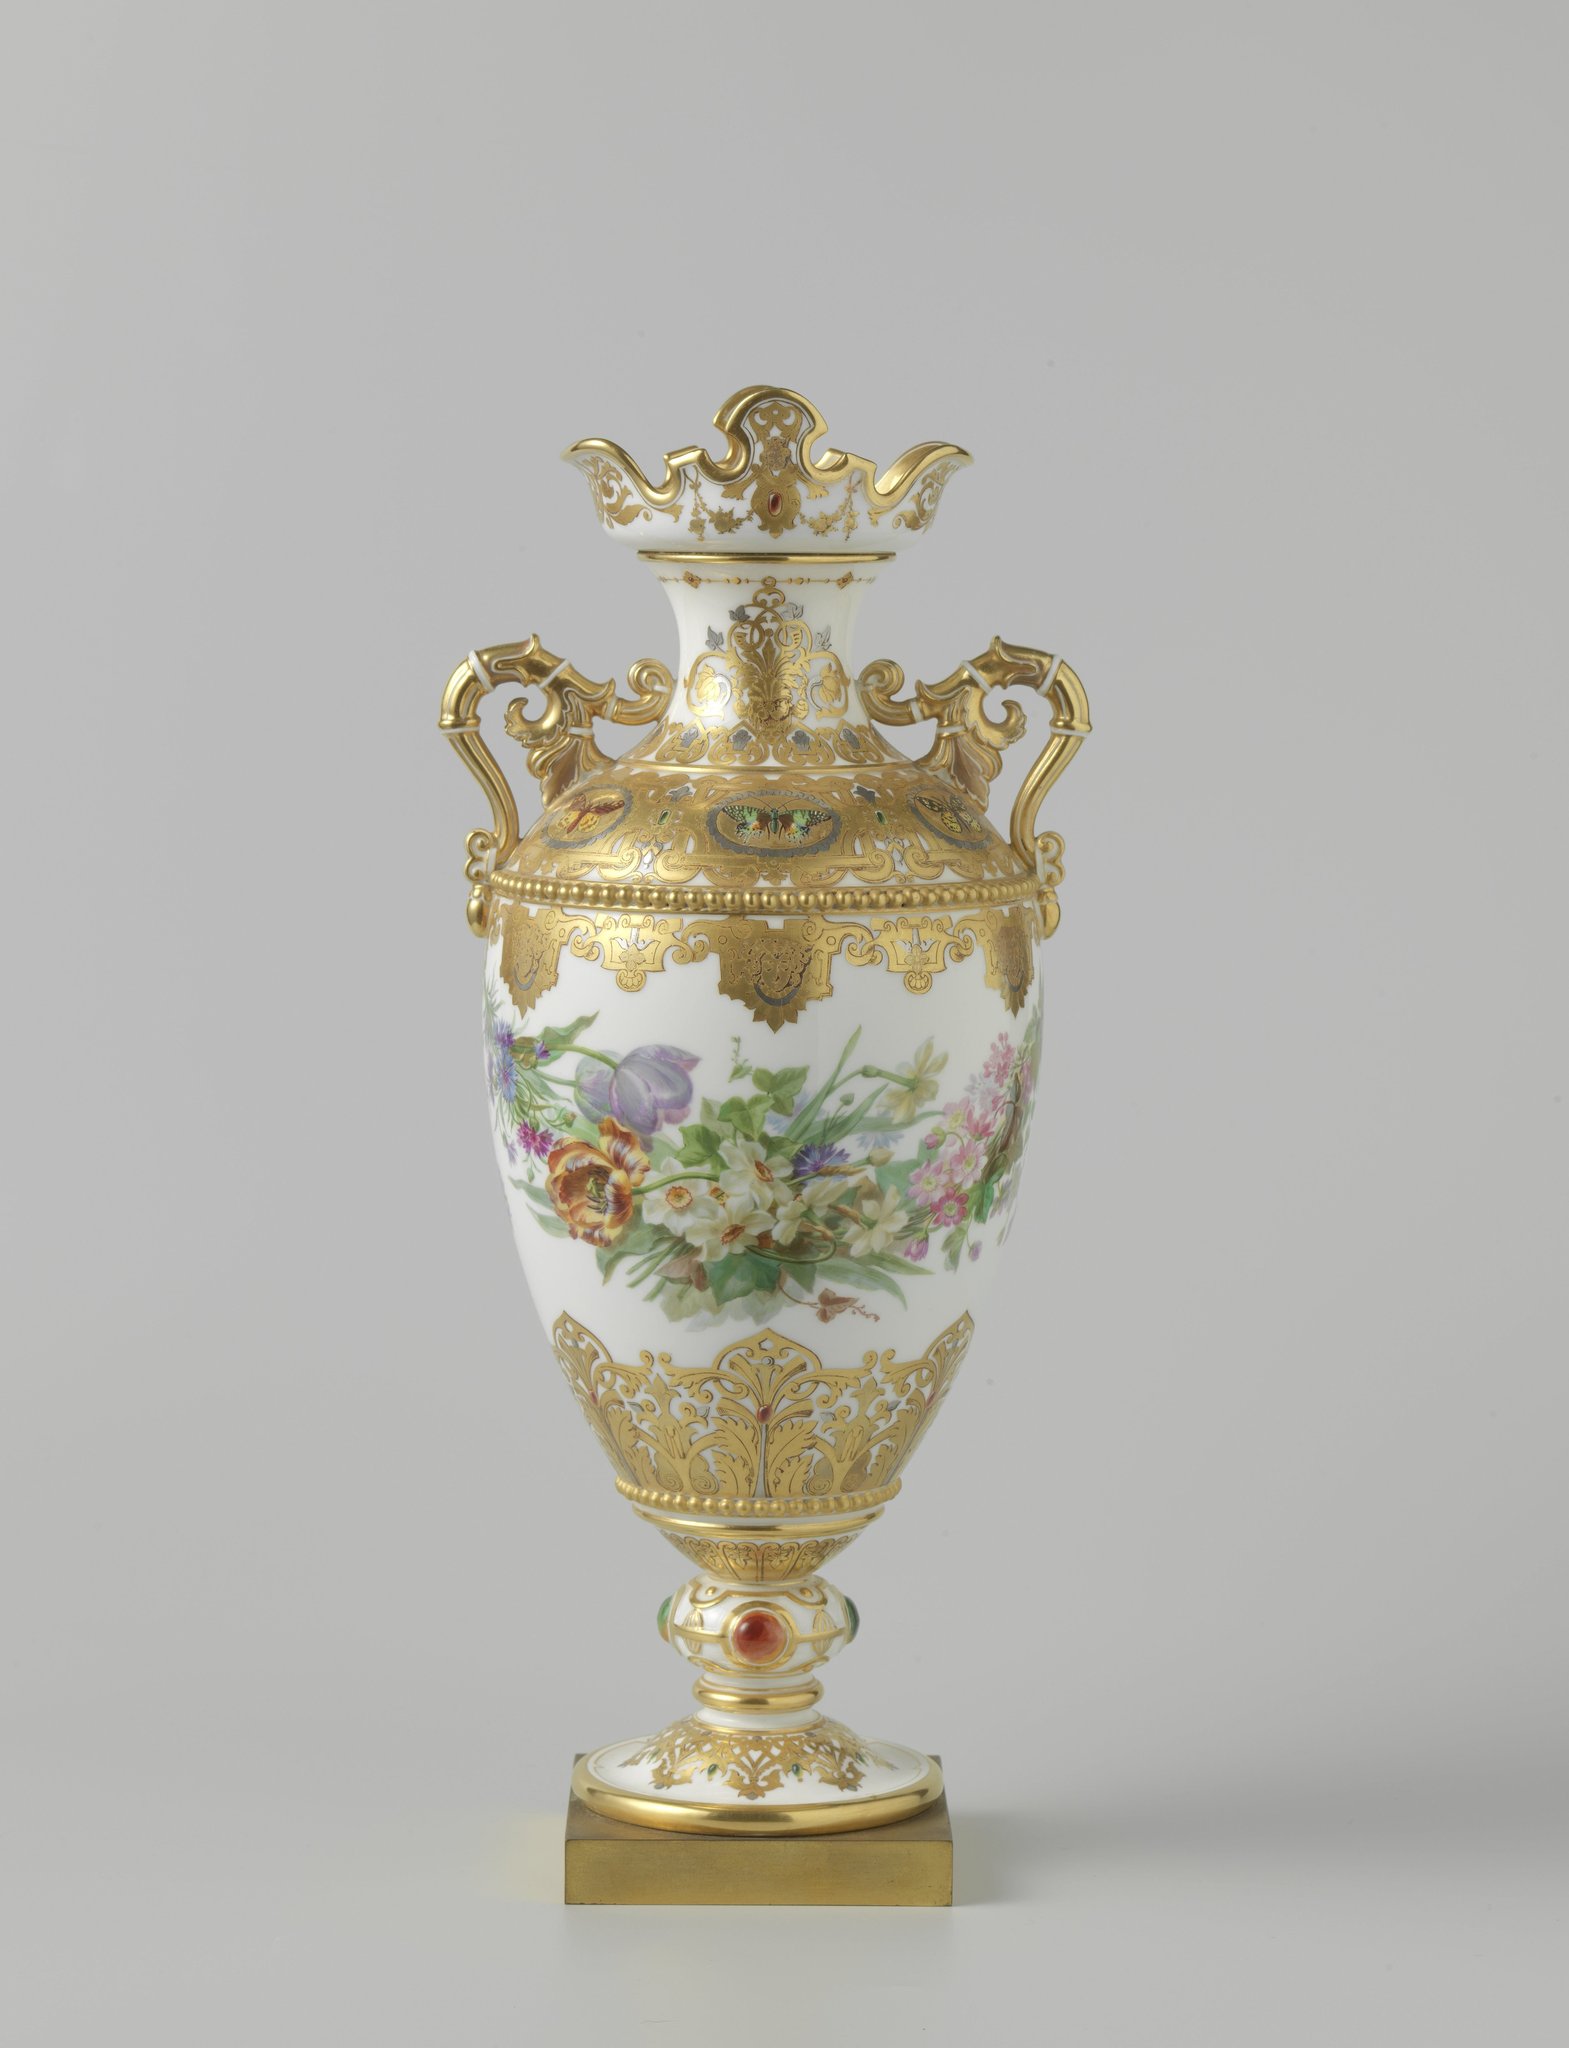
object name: vase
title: Pair of vases (Vases Adélaïde)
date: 1848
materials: bronze, gold, platinum, porcelain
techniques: gilding, painted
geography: sèvres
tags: flowers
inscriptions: mark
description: Vaas van porselein met hoog aangezette, kleine, in een bladkrul eindigende oren, op vierkante vergulde sokkel, beschilderd in goud en platina met renaissance-achtige ornamentranden met veelkleurige vlinders en driedimensionale "stenen", tussen de randen een brede wit gelaten zône waarop veelkleurige bloemslingers.